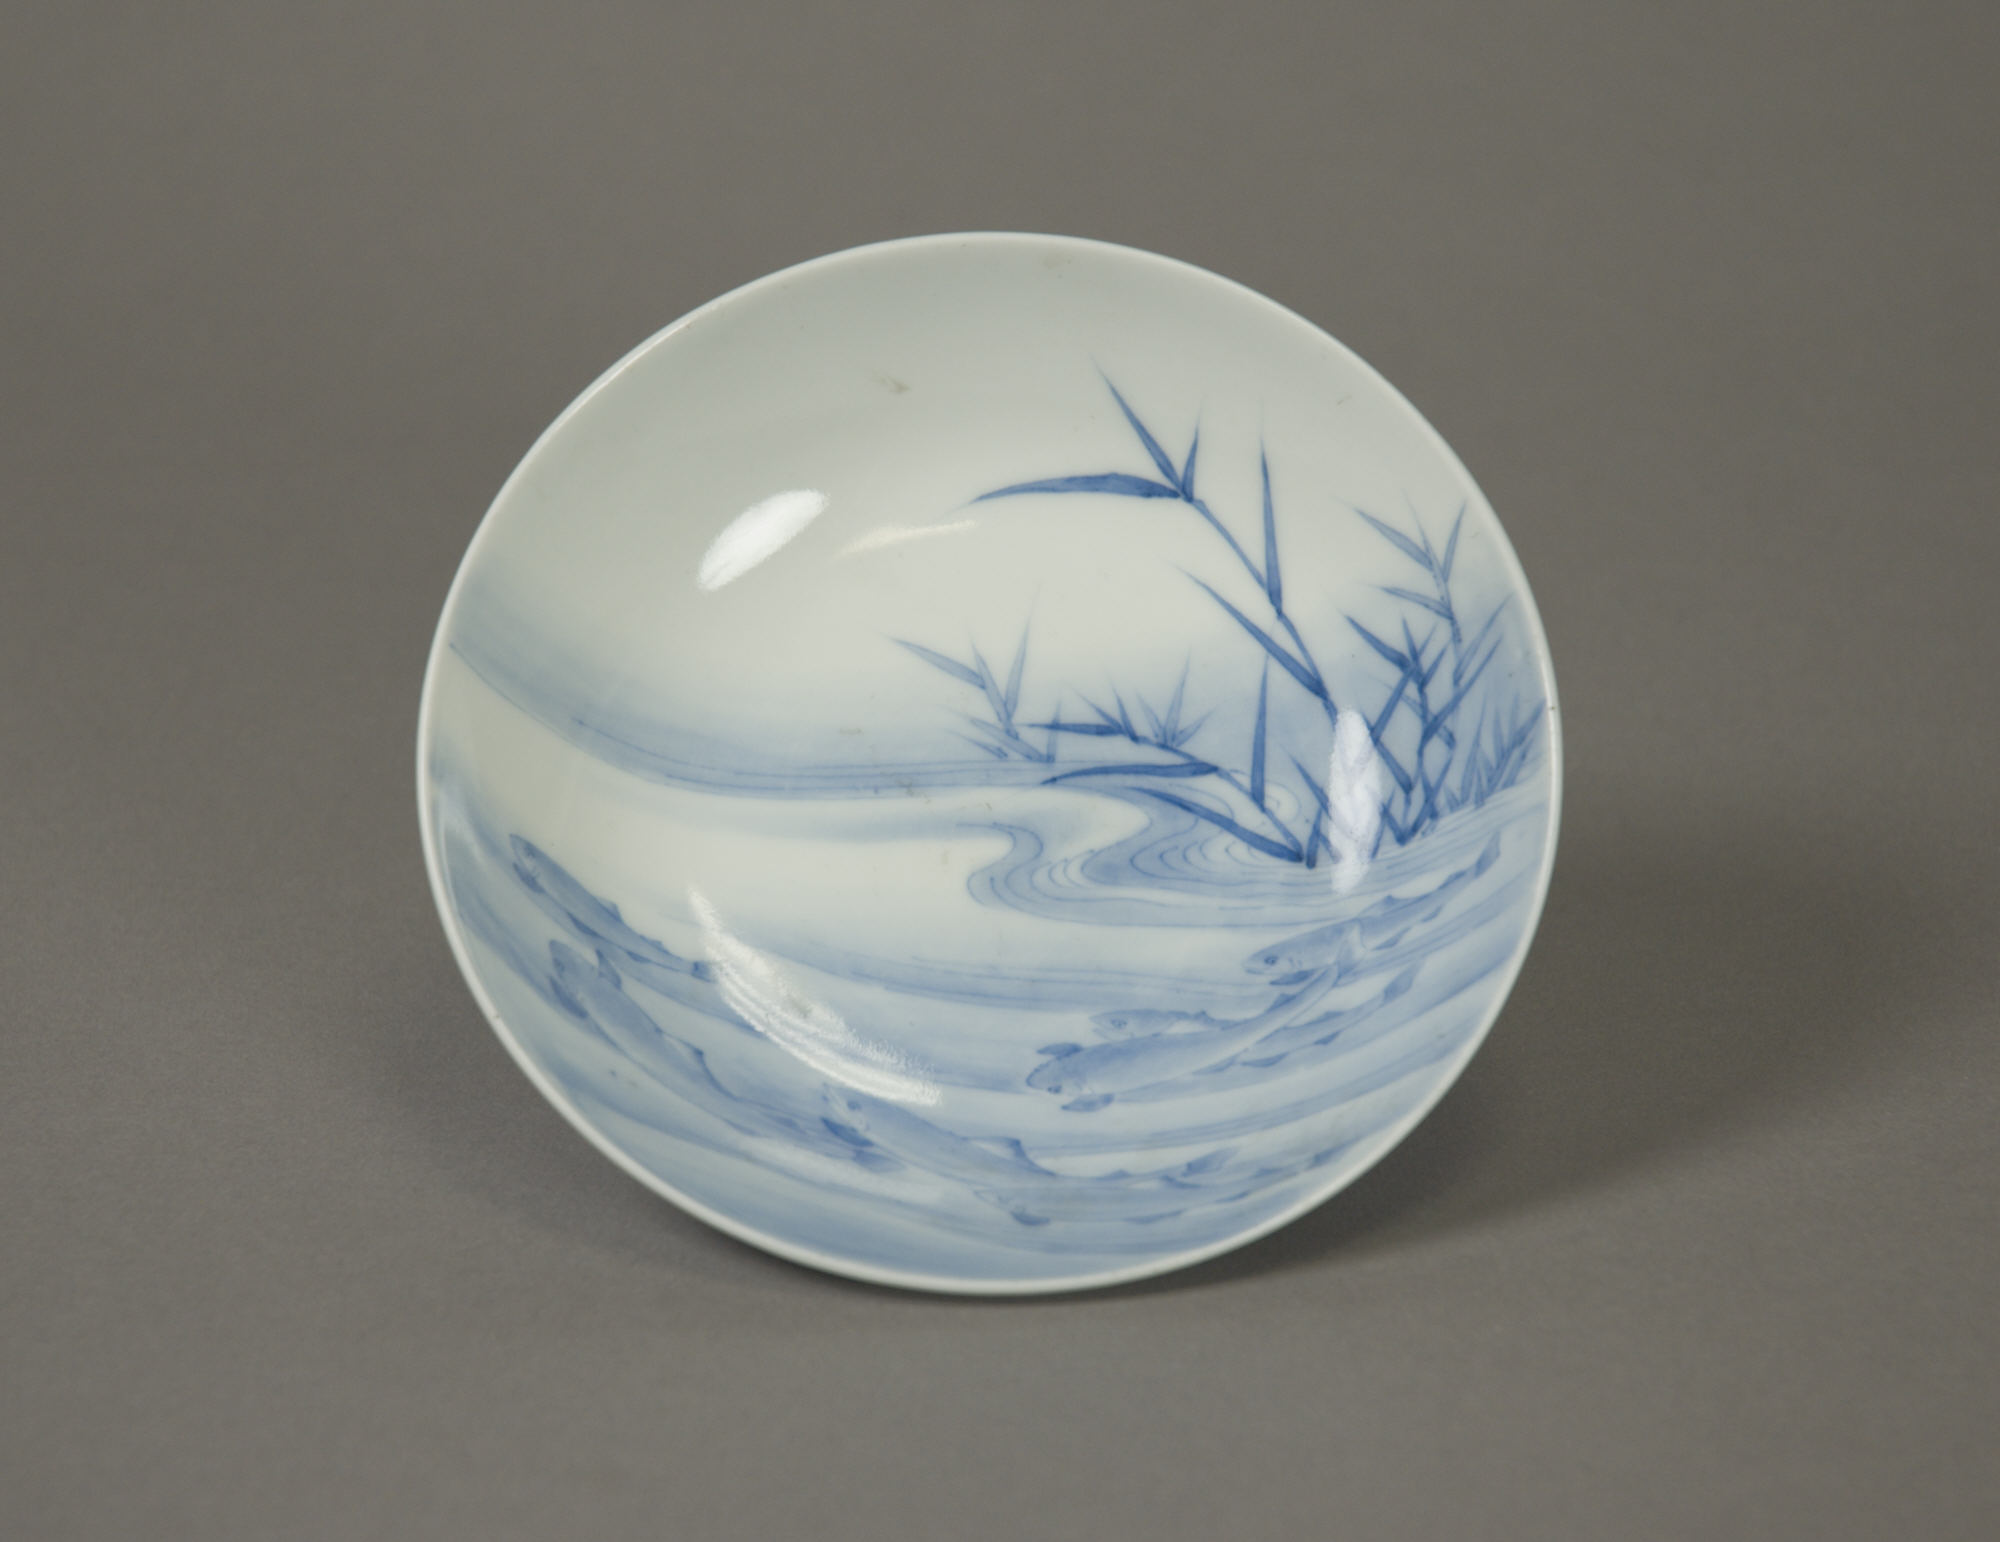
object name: dish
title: Dish with Fish in a Stream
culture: japanese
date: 1750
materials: glaze, porcelain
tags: fish,plants